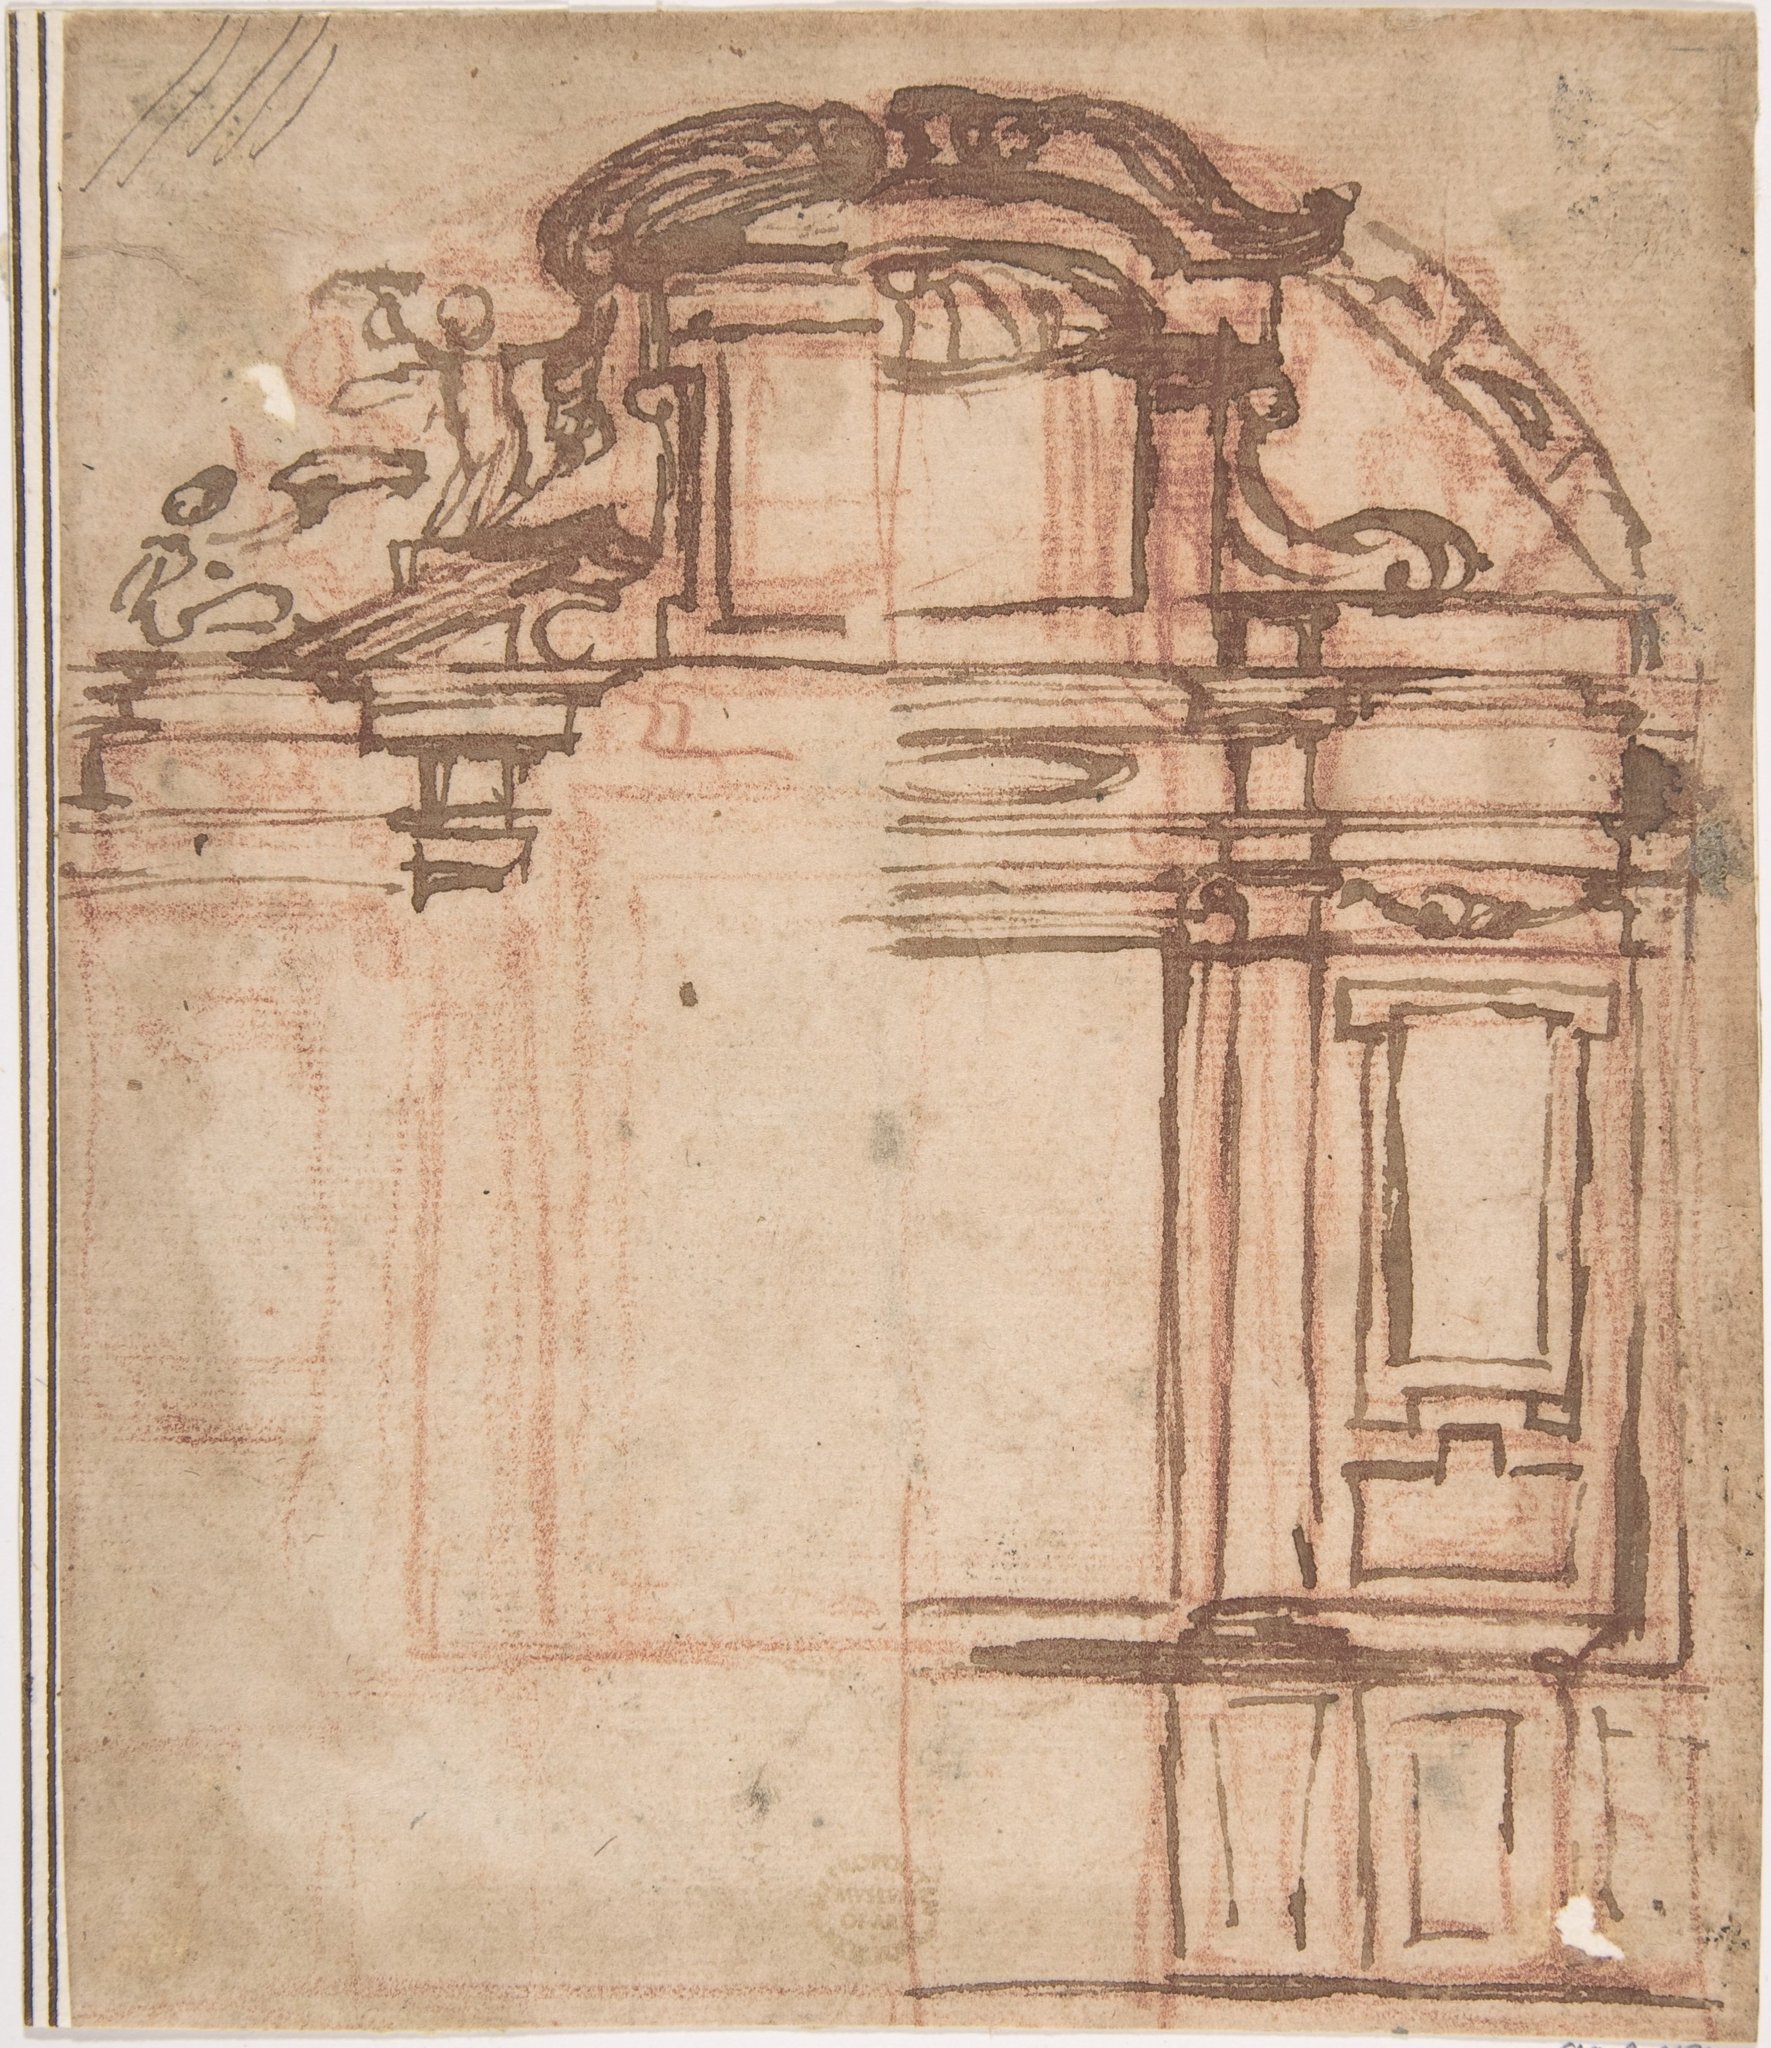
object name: drawing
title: Sketch for Wall Monument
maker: anonymous, italian, 16th century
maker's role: artist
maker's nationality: italian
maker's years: 1550-1600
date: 1501-1600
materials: chalk, ink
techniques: brush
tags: monuments